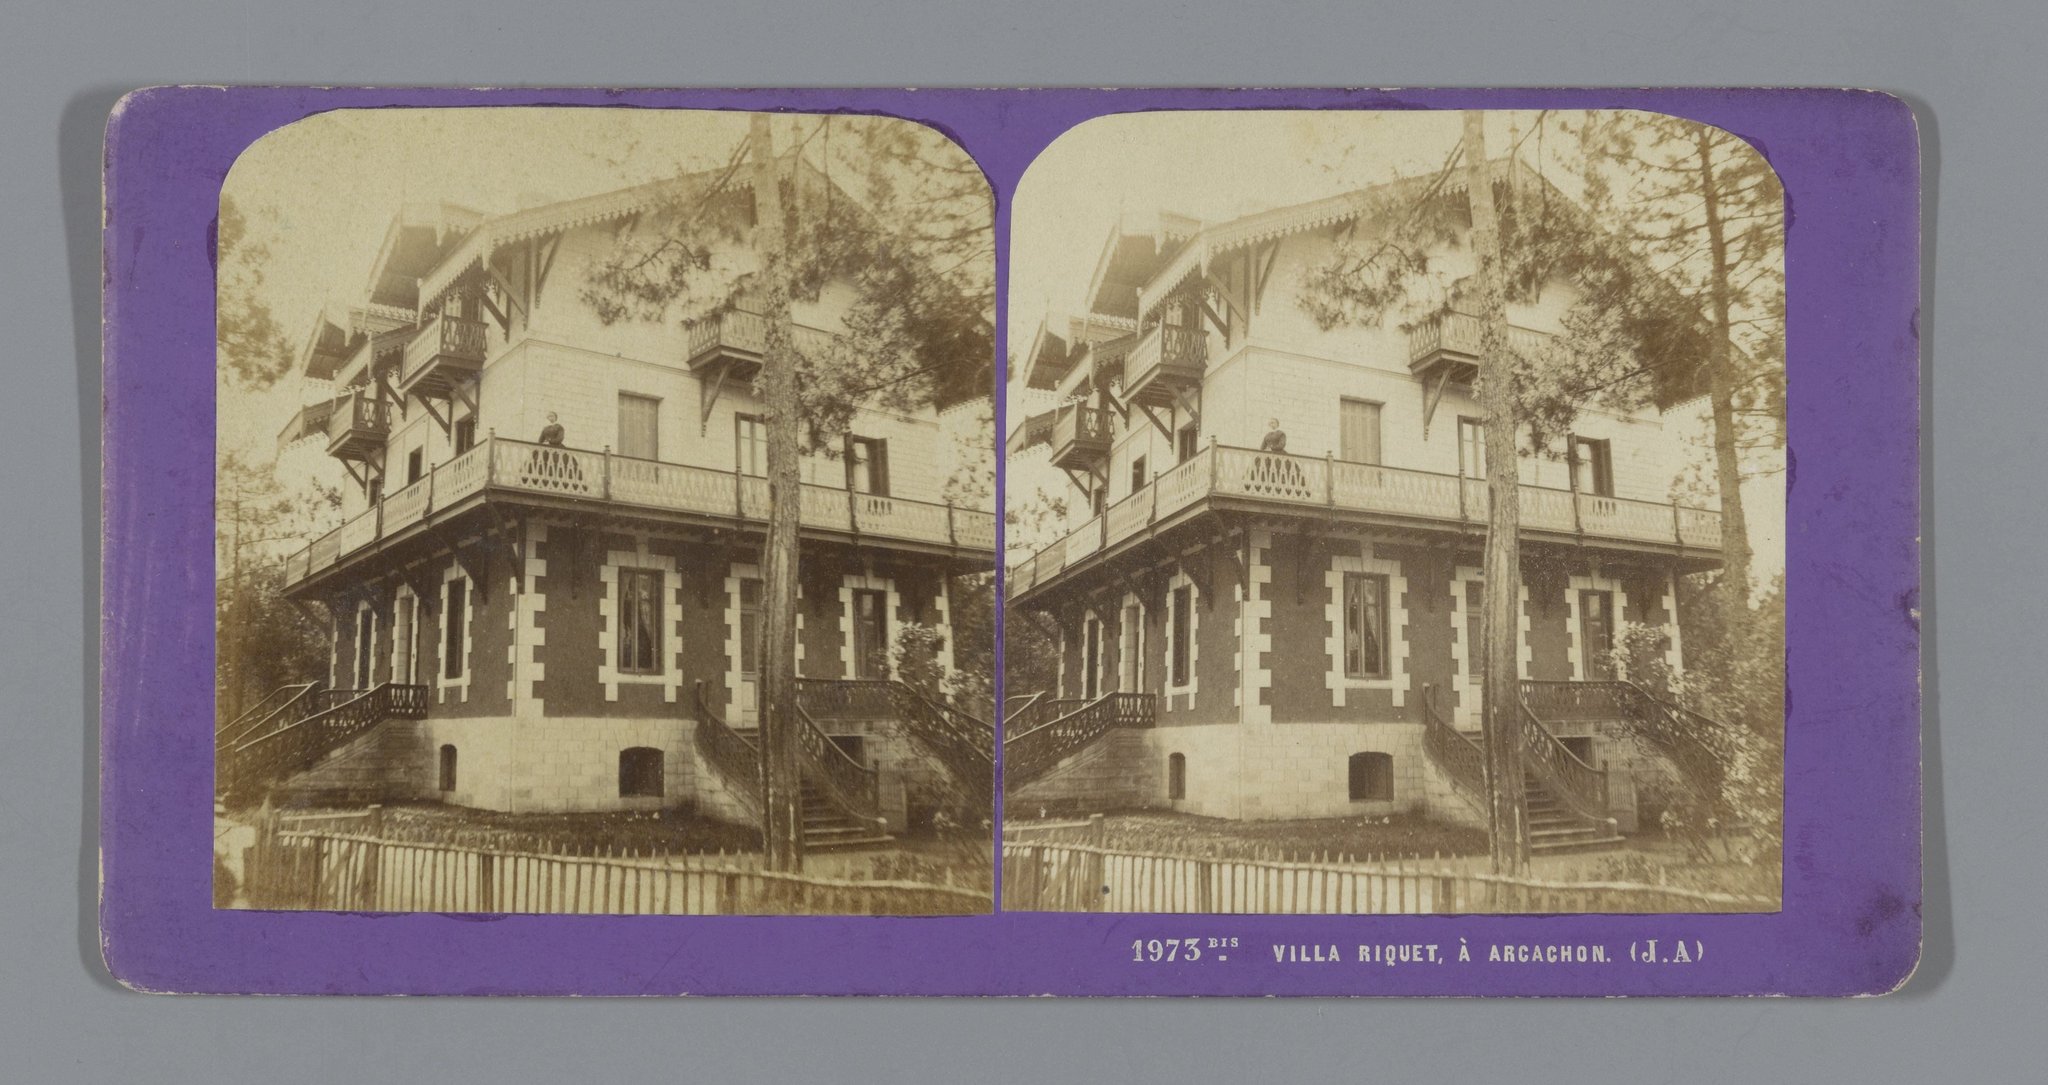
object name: stereograph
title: Villa Riquet, à Archachon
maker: jean andrieu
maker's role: fotograaf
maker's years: 1816-1872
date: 1862-1876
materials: cardboard, photographic support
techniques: albumen print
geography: arcachon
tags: rural housing, e.g. country-house, villa, cottage, façade (of house or building)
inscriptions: number: ‘1973bis.’